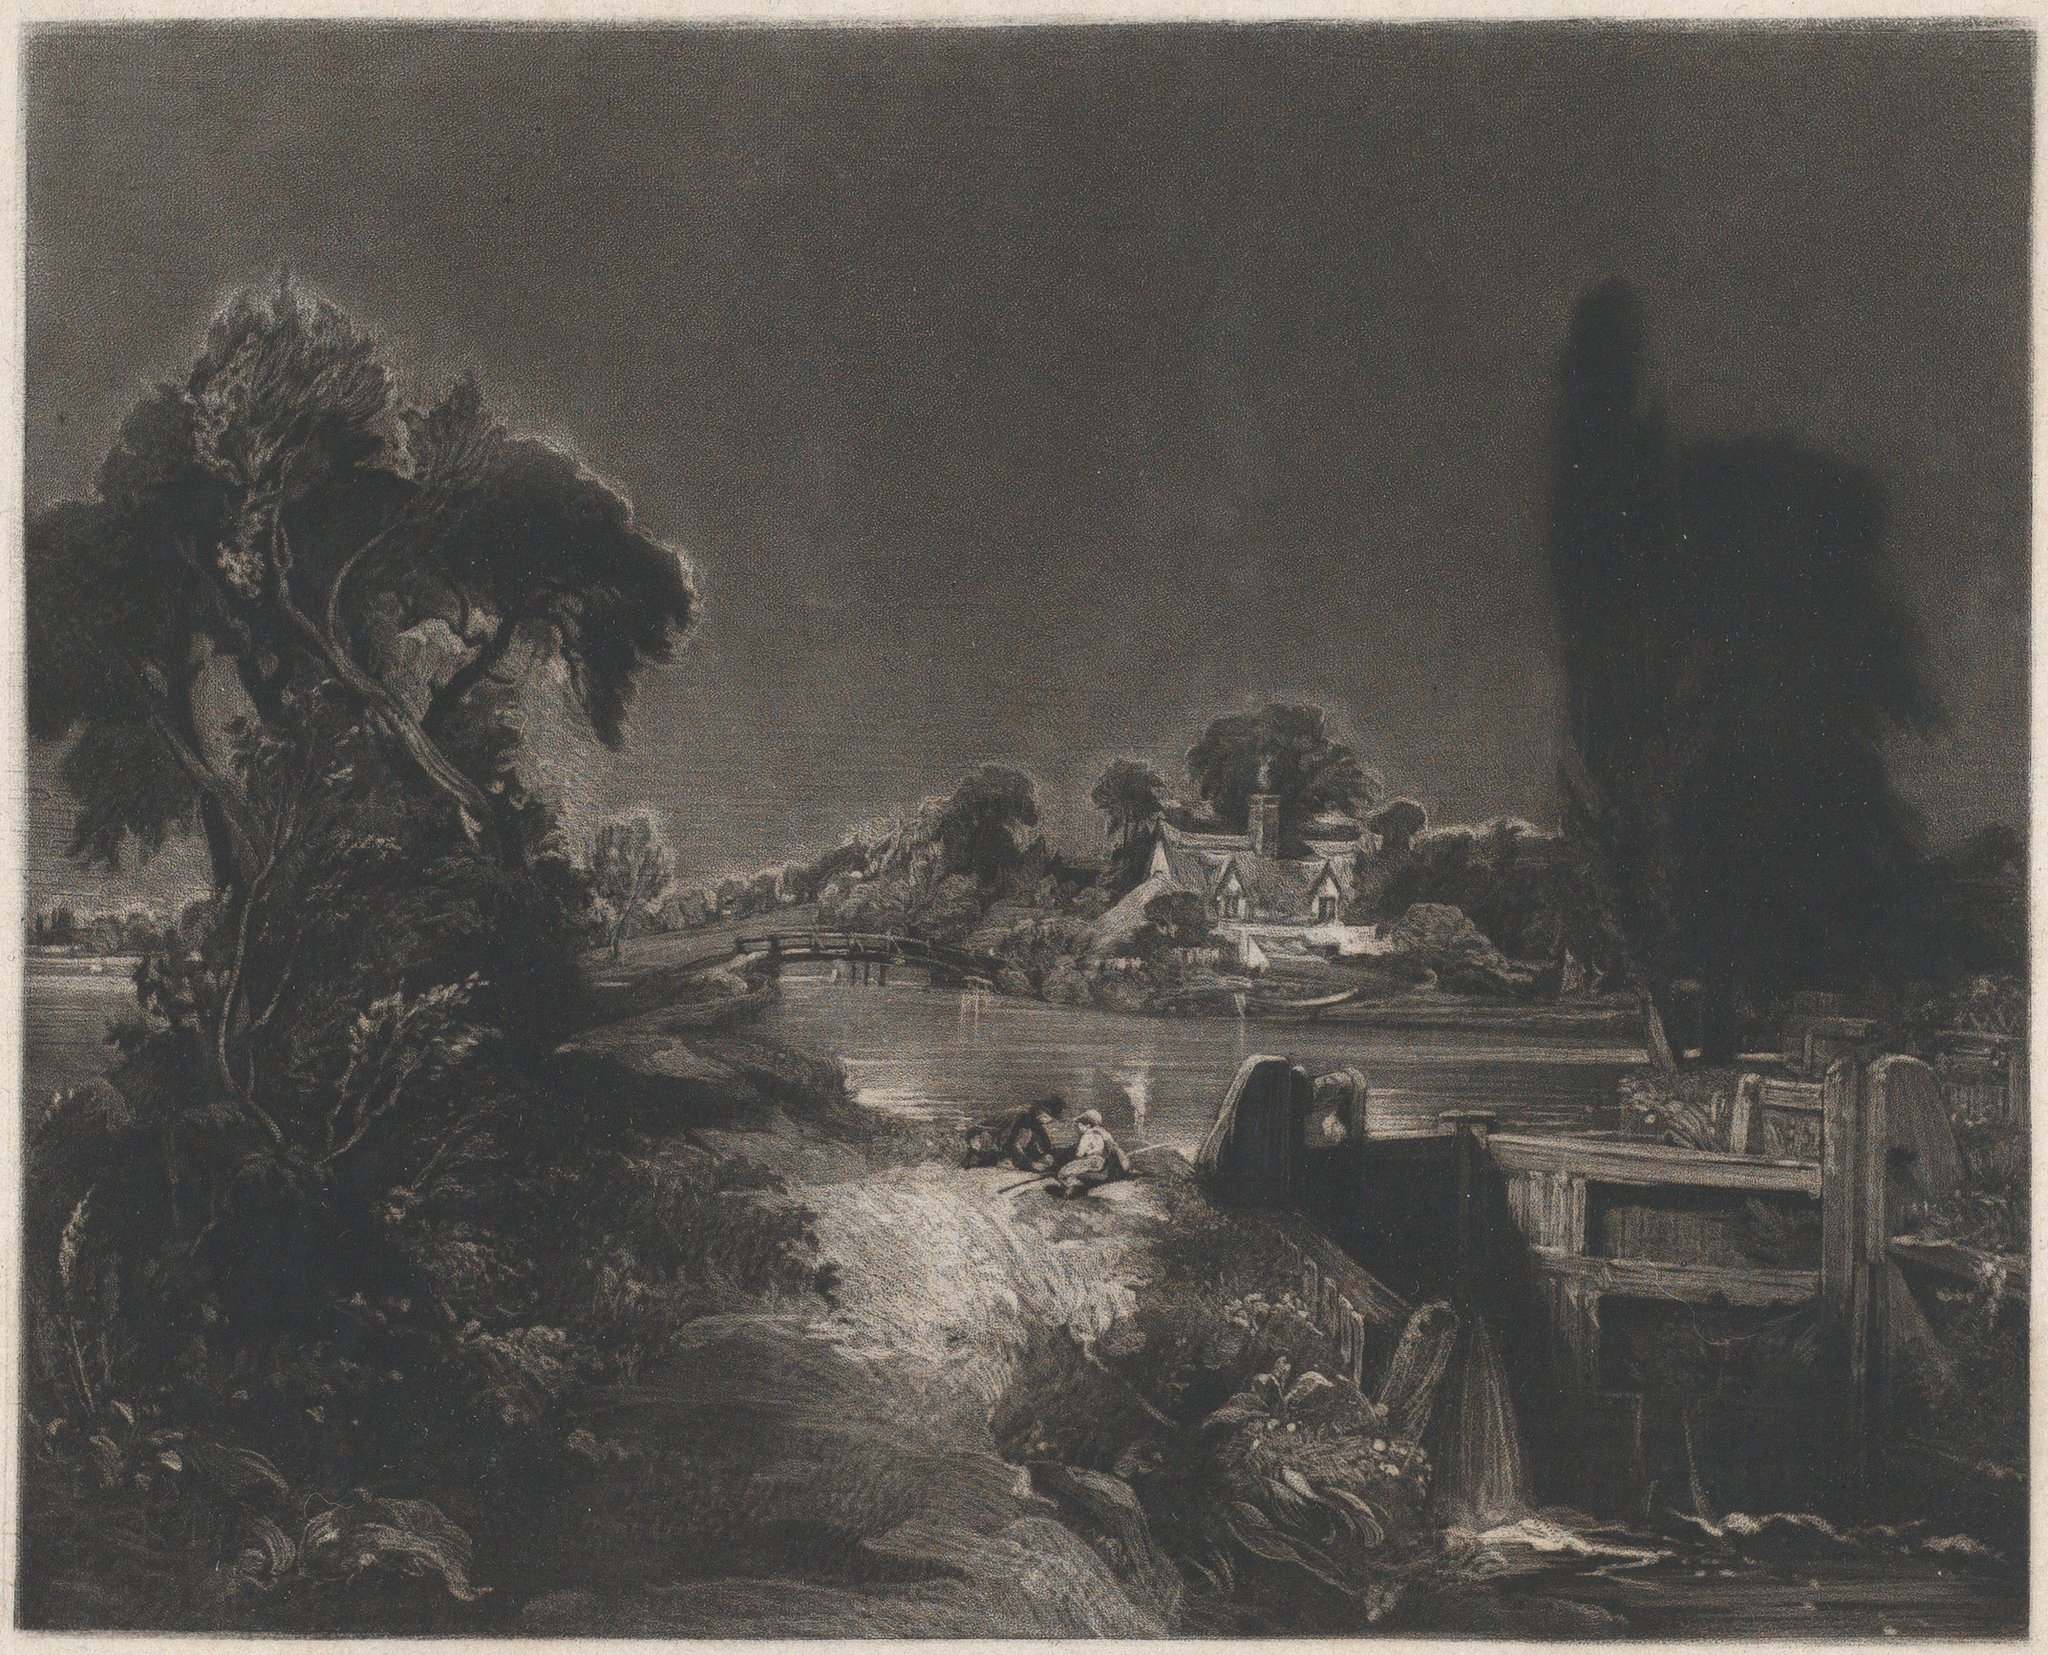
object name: print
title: A Lock on the Stour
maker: david lucas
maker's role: artist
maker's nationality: british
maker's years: 1802-1881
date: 1830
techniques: mezzotint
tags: bridges,rivers,landscapes